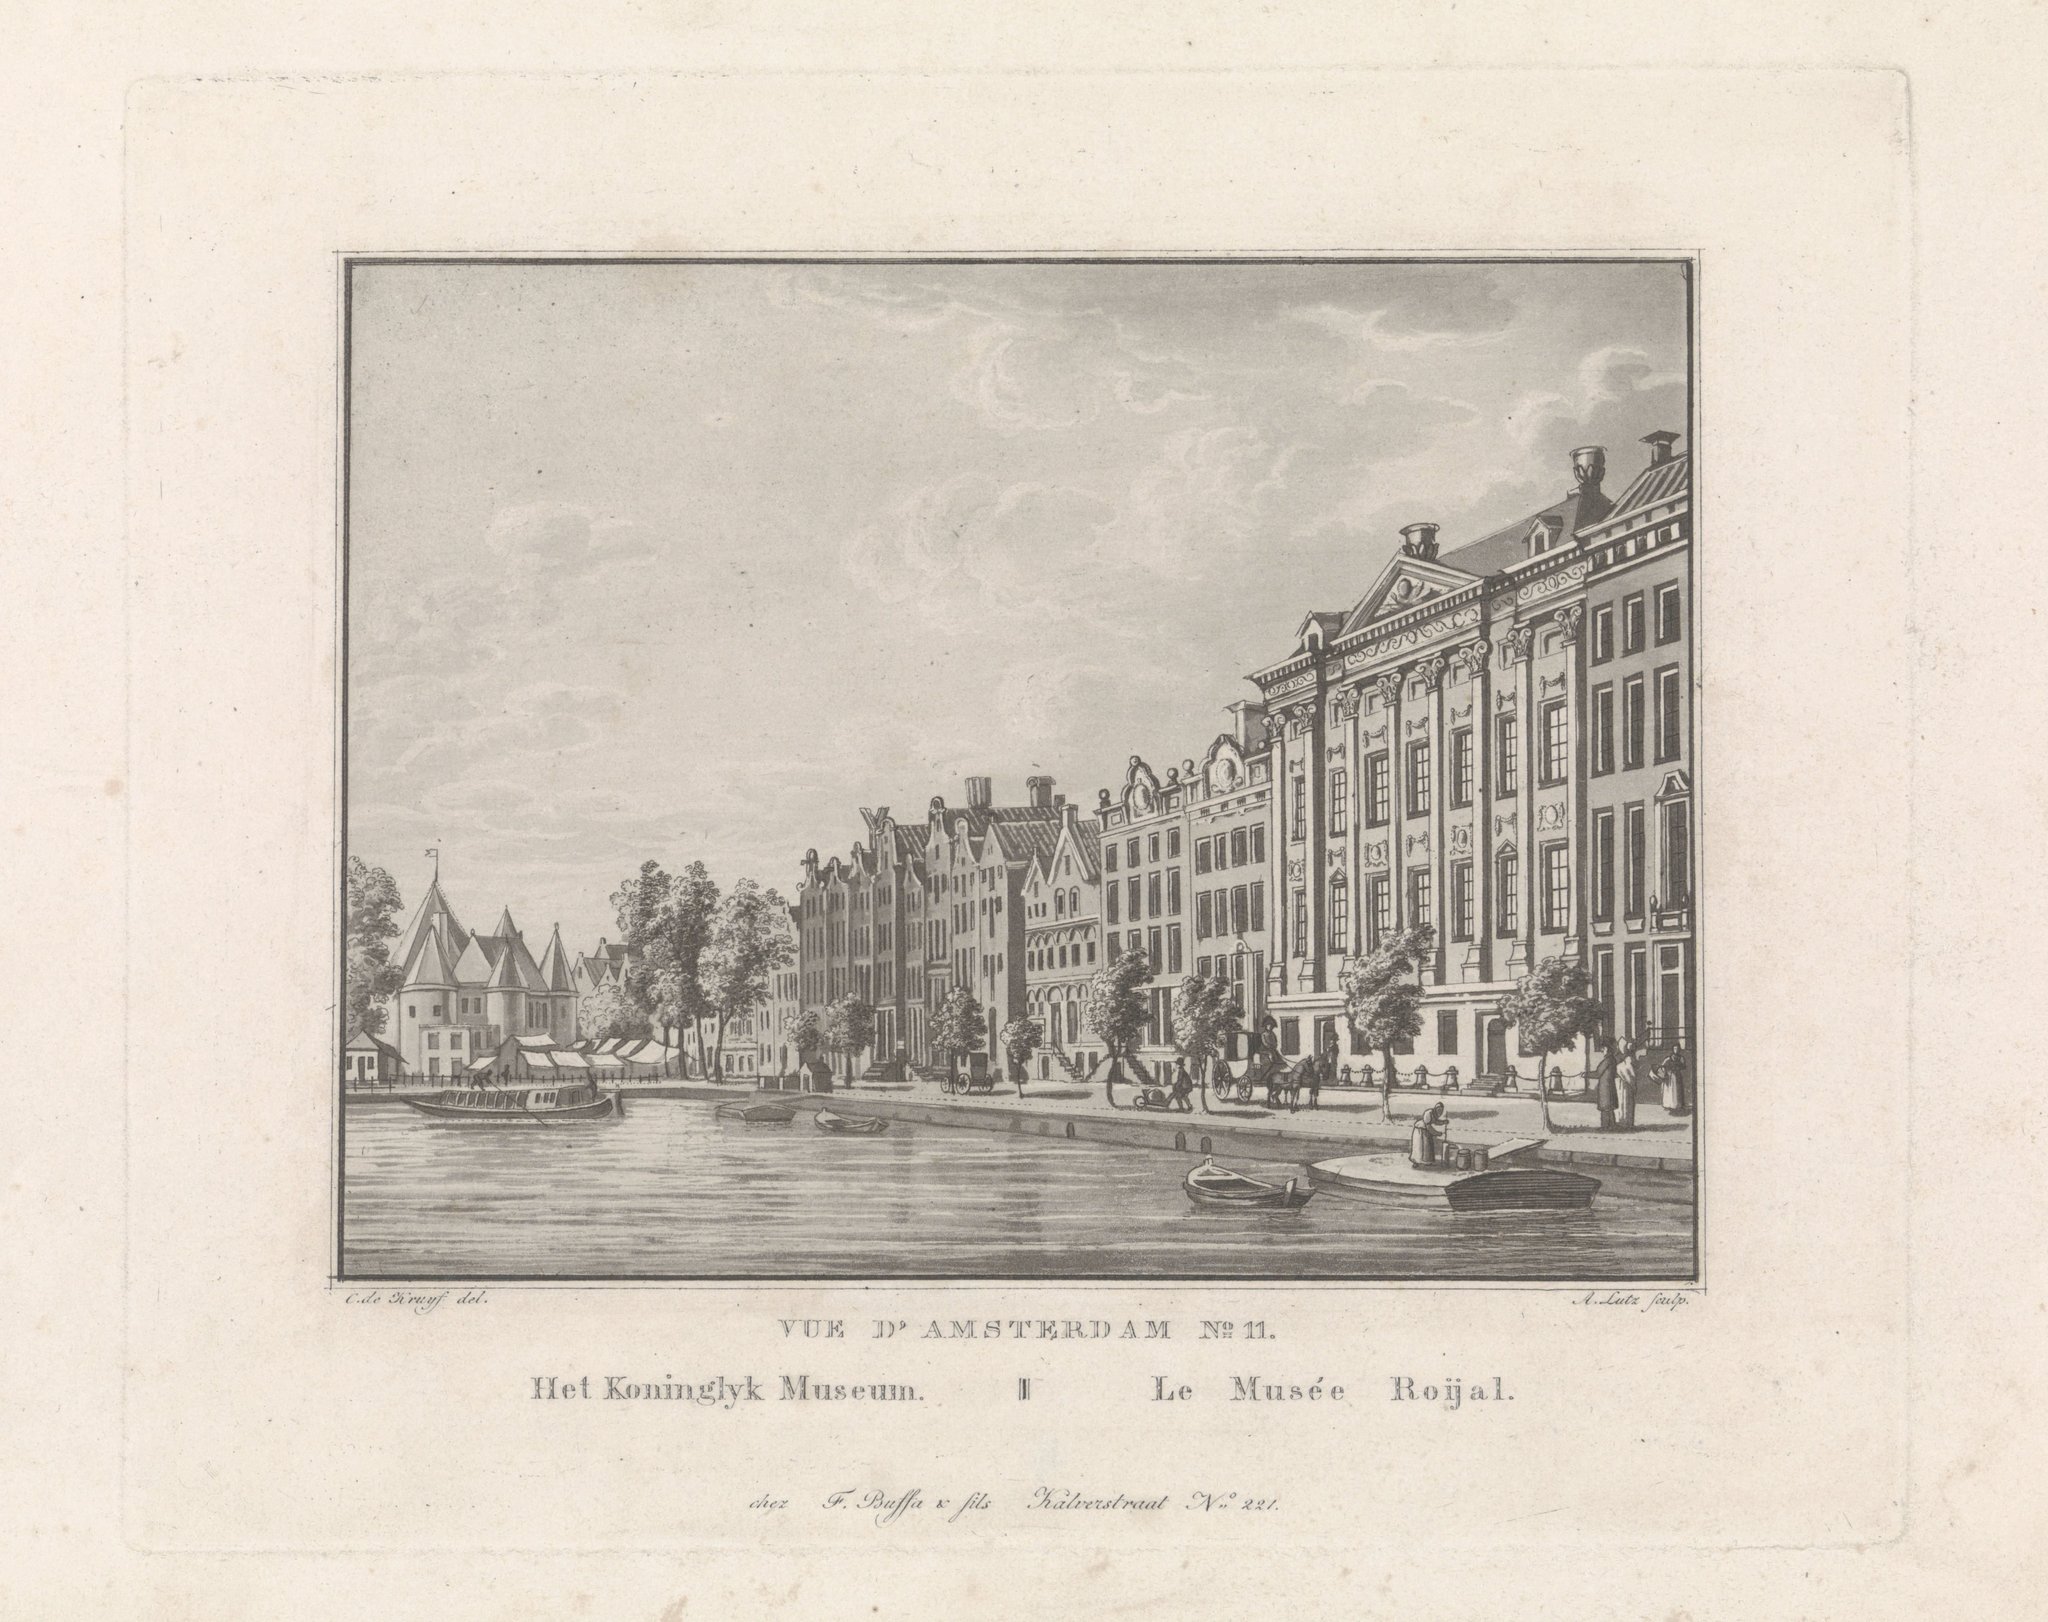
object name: print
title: Het Koninglyk Museum / Le Musée Roijal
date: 1825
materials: paper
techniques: aquatint, etching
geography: the hague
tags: canals, waters (in city)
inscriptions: collector's mark: Lugt 2760, collector's mark: Lugt 2228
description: Gezicht op het Trippenhuis of het Koninklijk Museum aan de Kloveniersburgwal te Amsterdam. In de verte de Waag op de Nieuwmarkt.